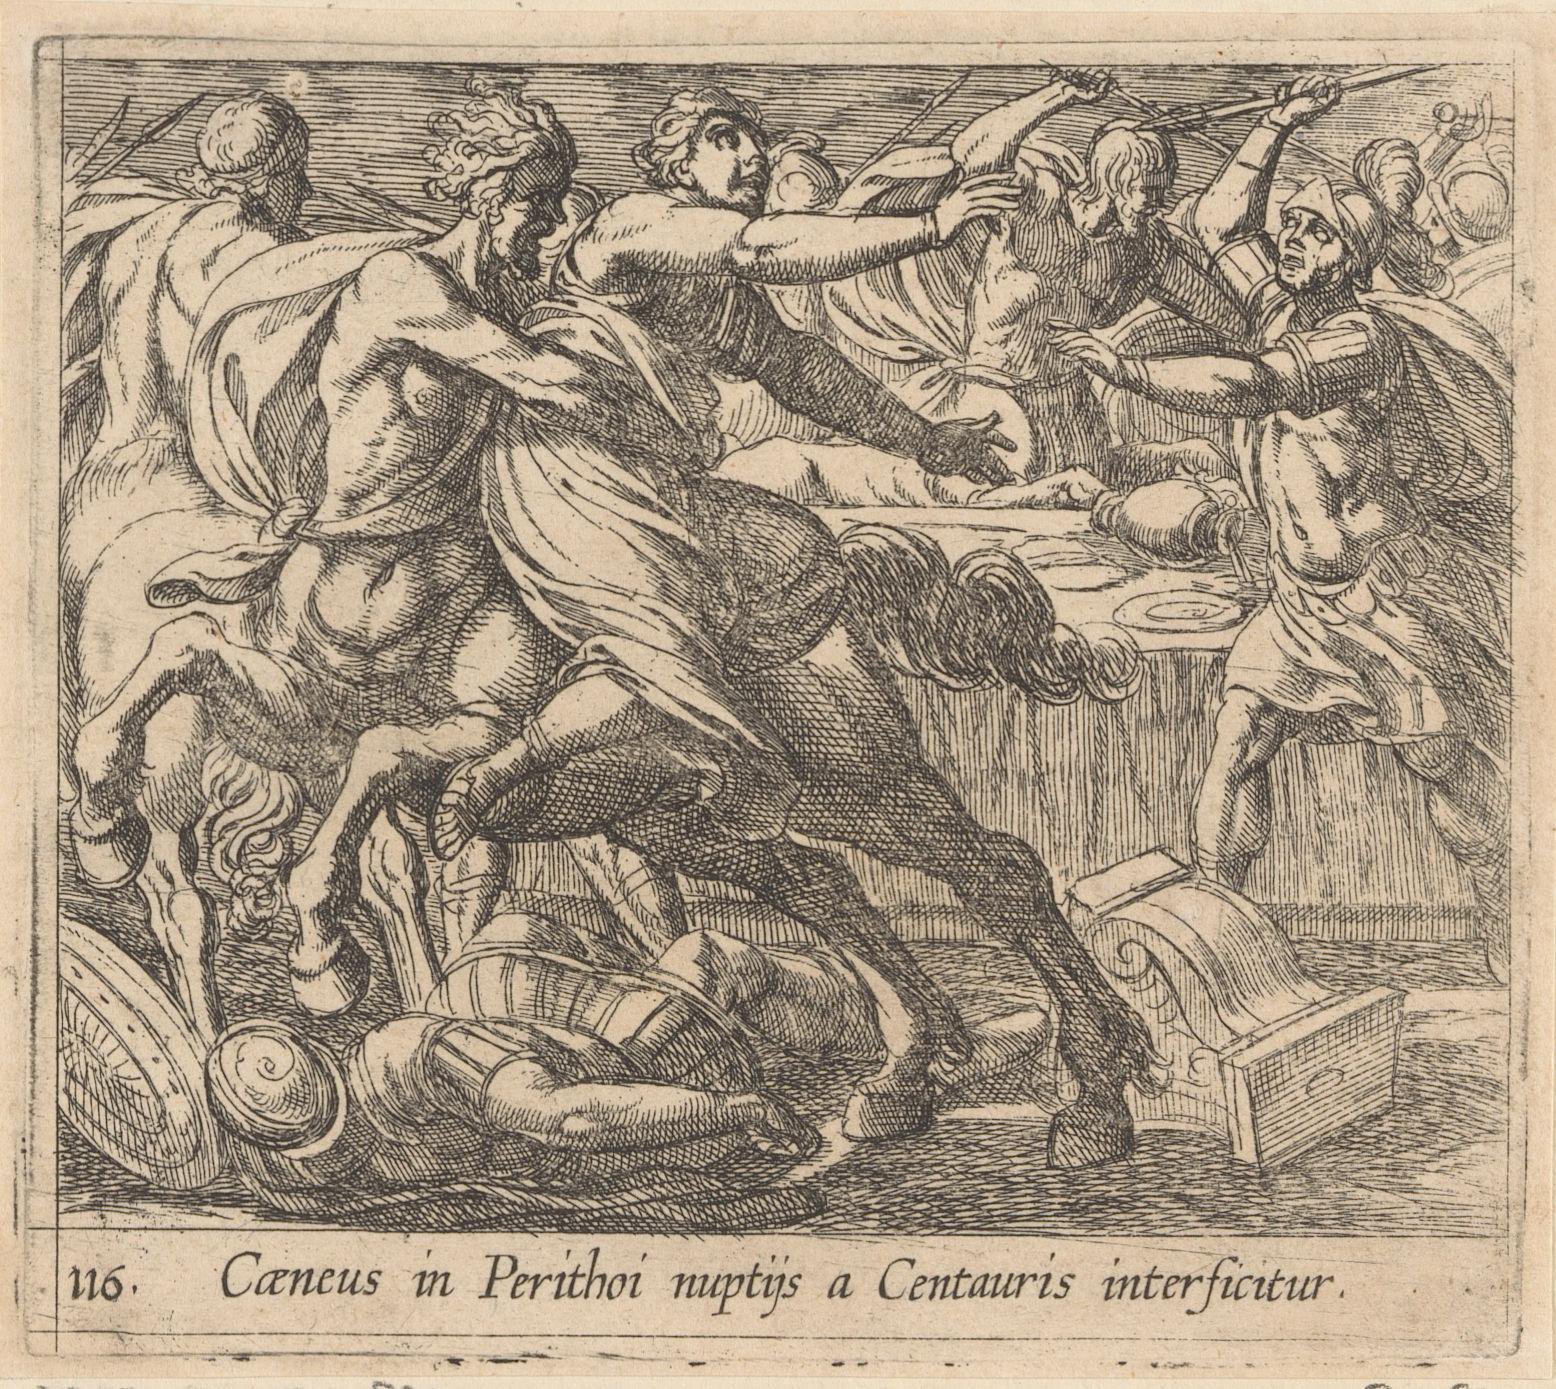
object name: print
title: Metamorfosen van Ovidius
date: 1606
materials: paper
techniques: etching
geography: italy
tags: transgender, transsexual, fight of lapiths and centaurs at the wedding of pirithous and hippodamia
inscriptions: collector's mark: Lugt 240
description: Deze prent maakt deel uit van een reeks van 150 prenten (+ titelprent) met voorstellingen van de Metamorfosen van Ovidius. Caeneus was ooit een vrouw, Caenis, maar is na door Poseidon te zijn verkracht op haar verzoek veranderd in een man. Caenaeus kon niet door wapens worden verslagen. Hij werd tijdens de strijd uiteindelijk gedood door Centauren die hem bedolven onder een grote stapel bomen.